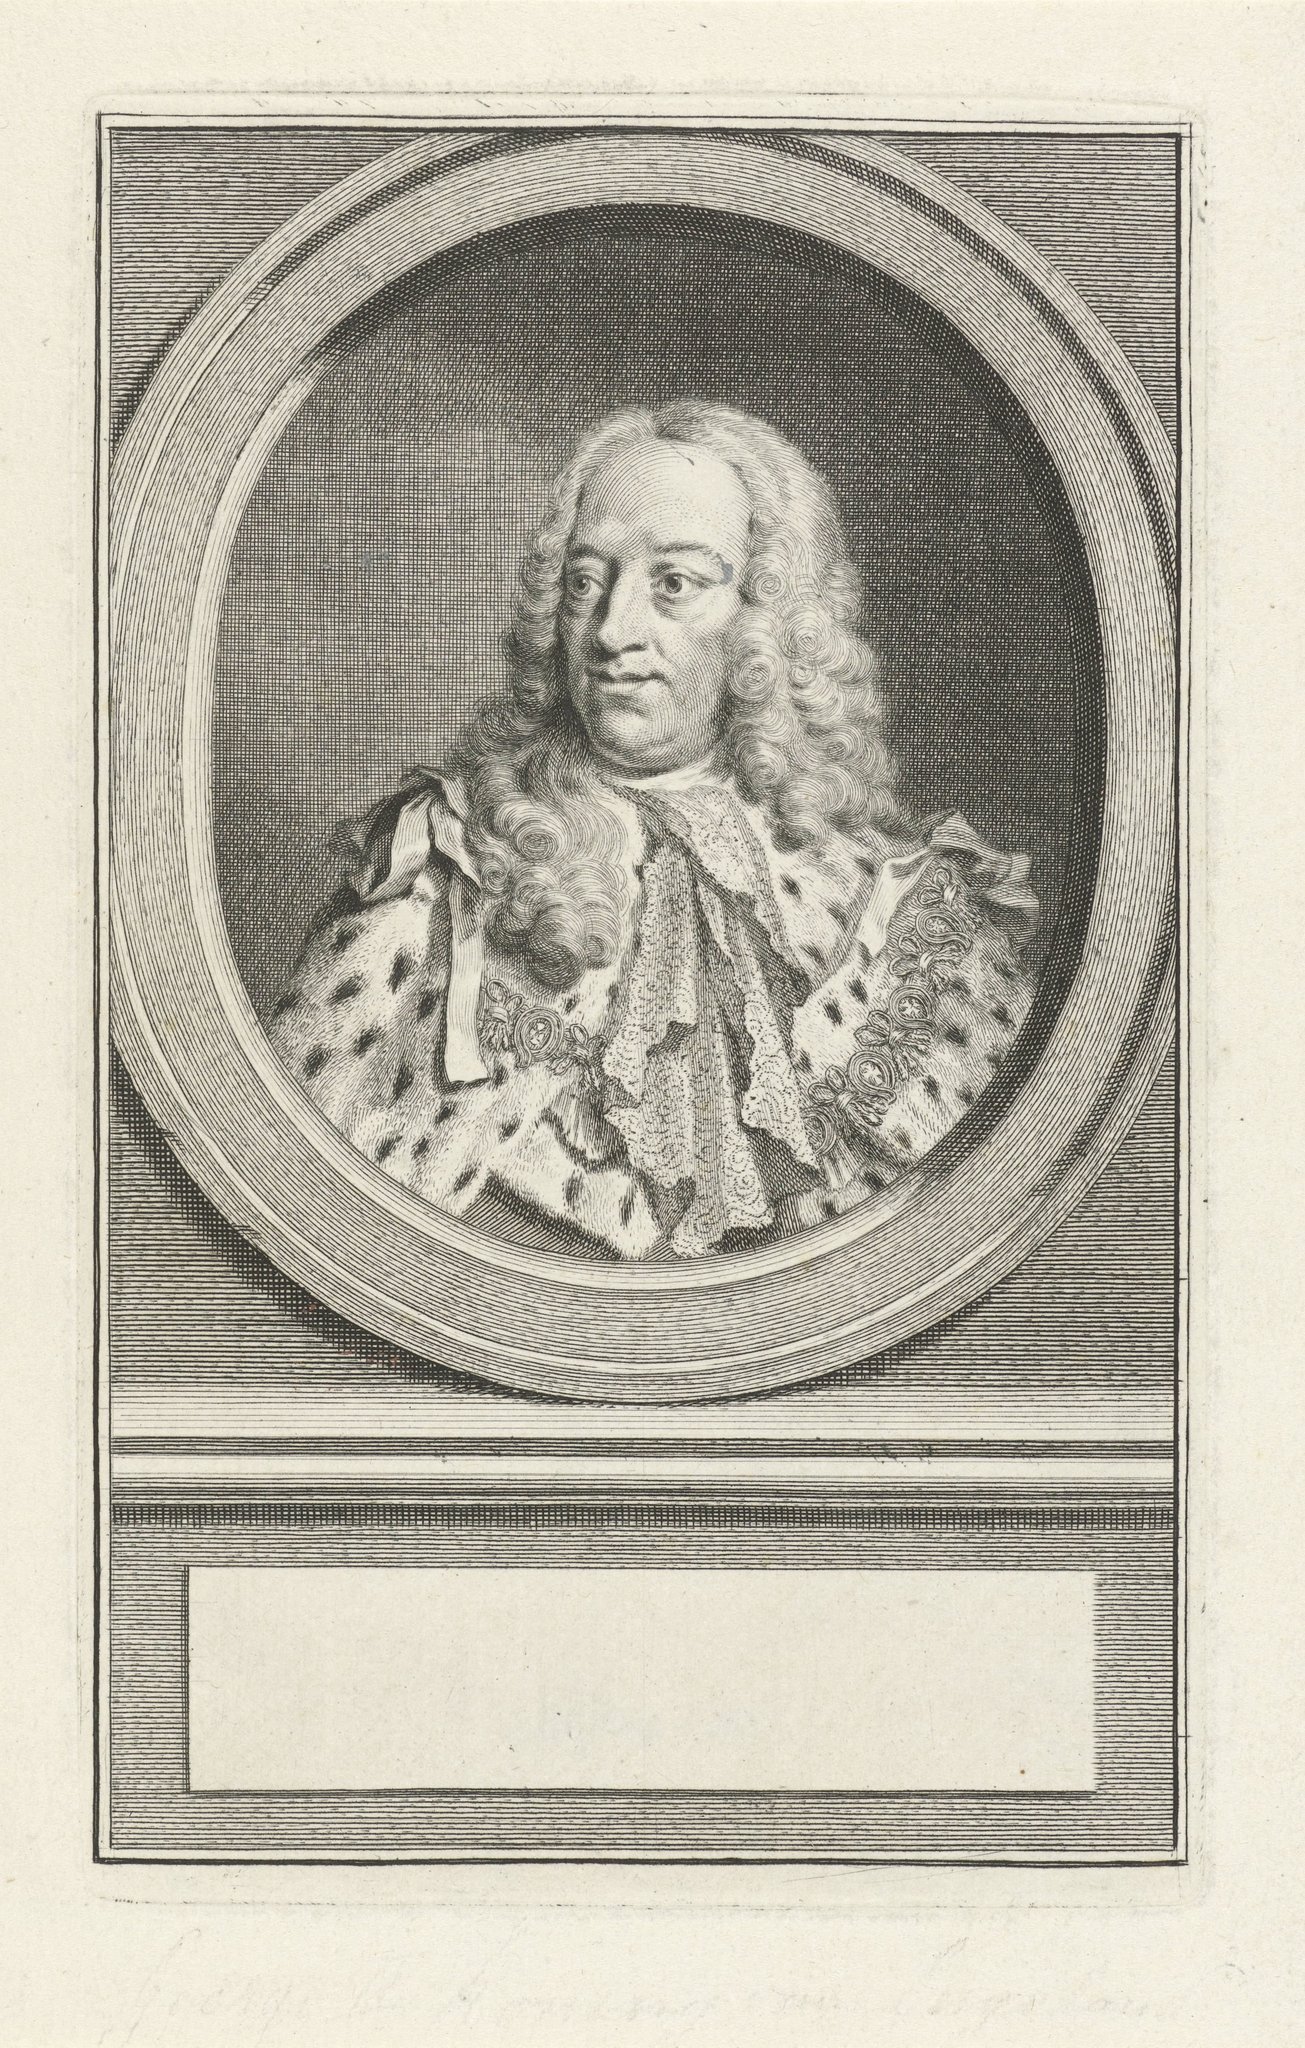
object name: print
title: Portret van George II Augustus, koning van Engeland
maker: jacob houbraken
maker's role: draughtsman, print maker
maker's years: 1698-1780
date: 1752-1754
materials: paper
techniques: engraving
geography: amsterdam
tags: london, george ii augustus (koning van groot-brittannië)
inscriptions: collector's mark: Lugt 240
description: George II Augustus, koning van Engeland, gekleed in een koningsmantel. Buste in ovaal, rustend op een plint waarop een leeg veld voor zijn naam.